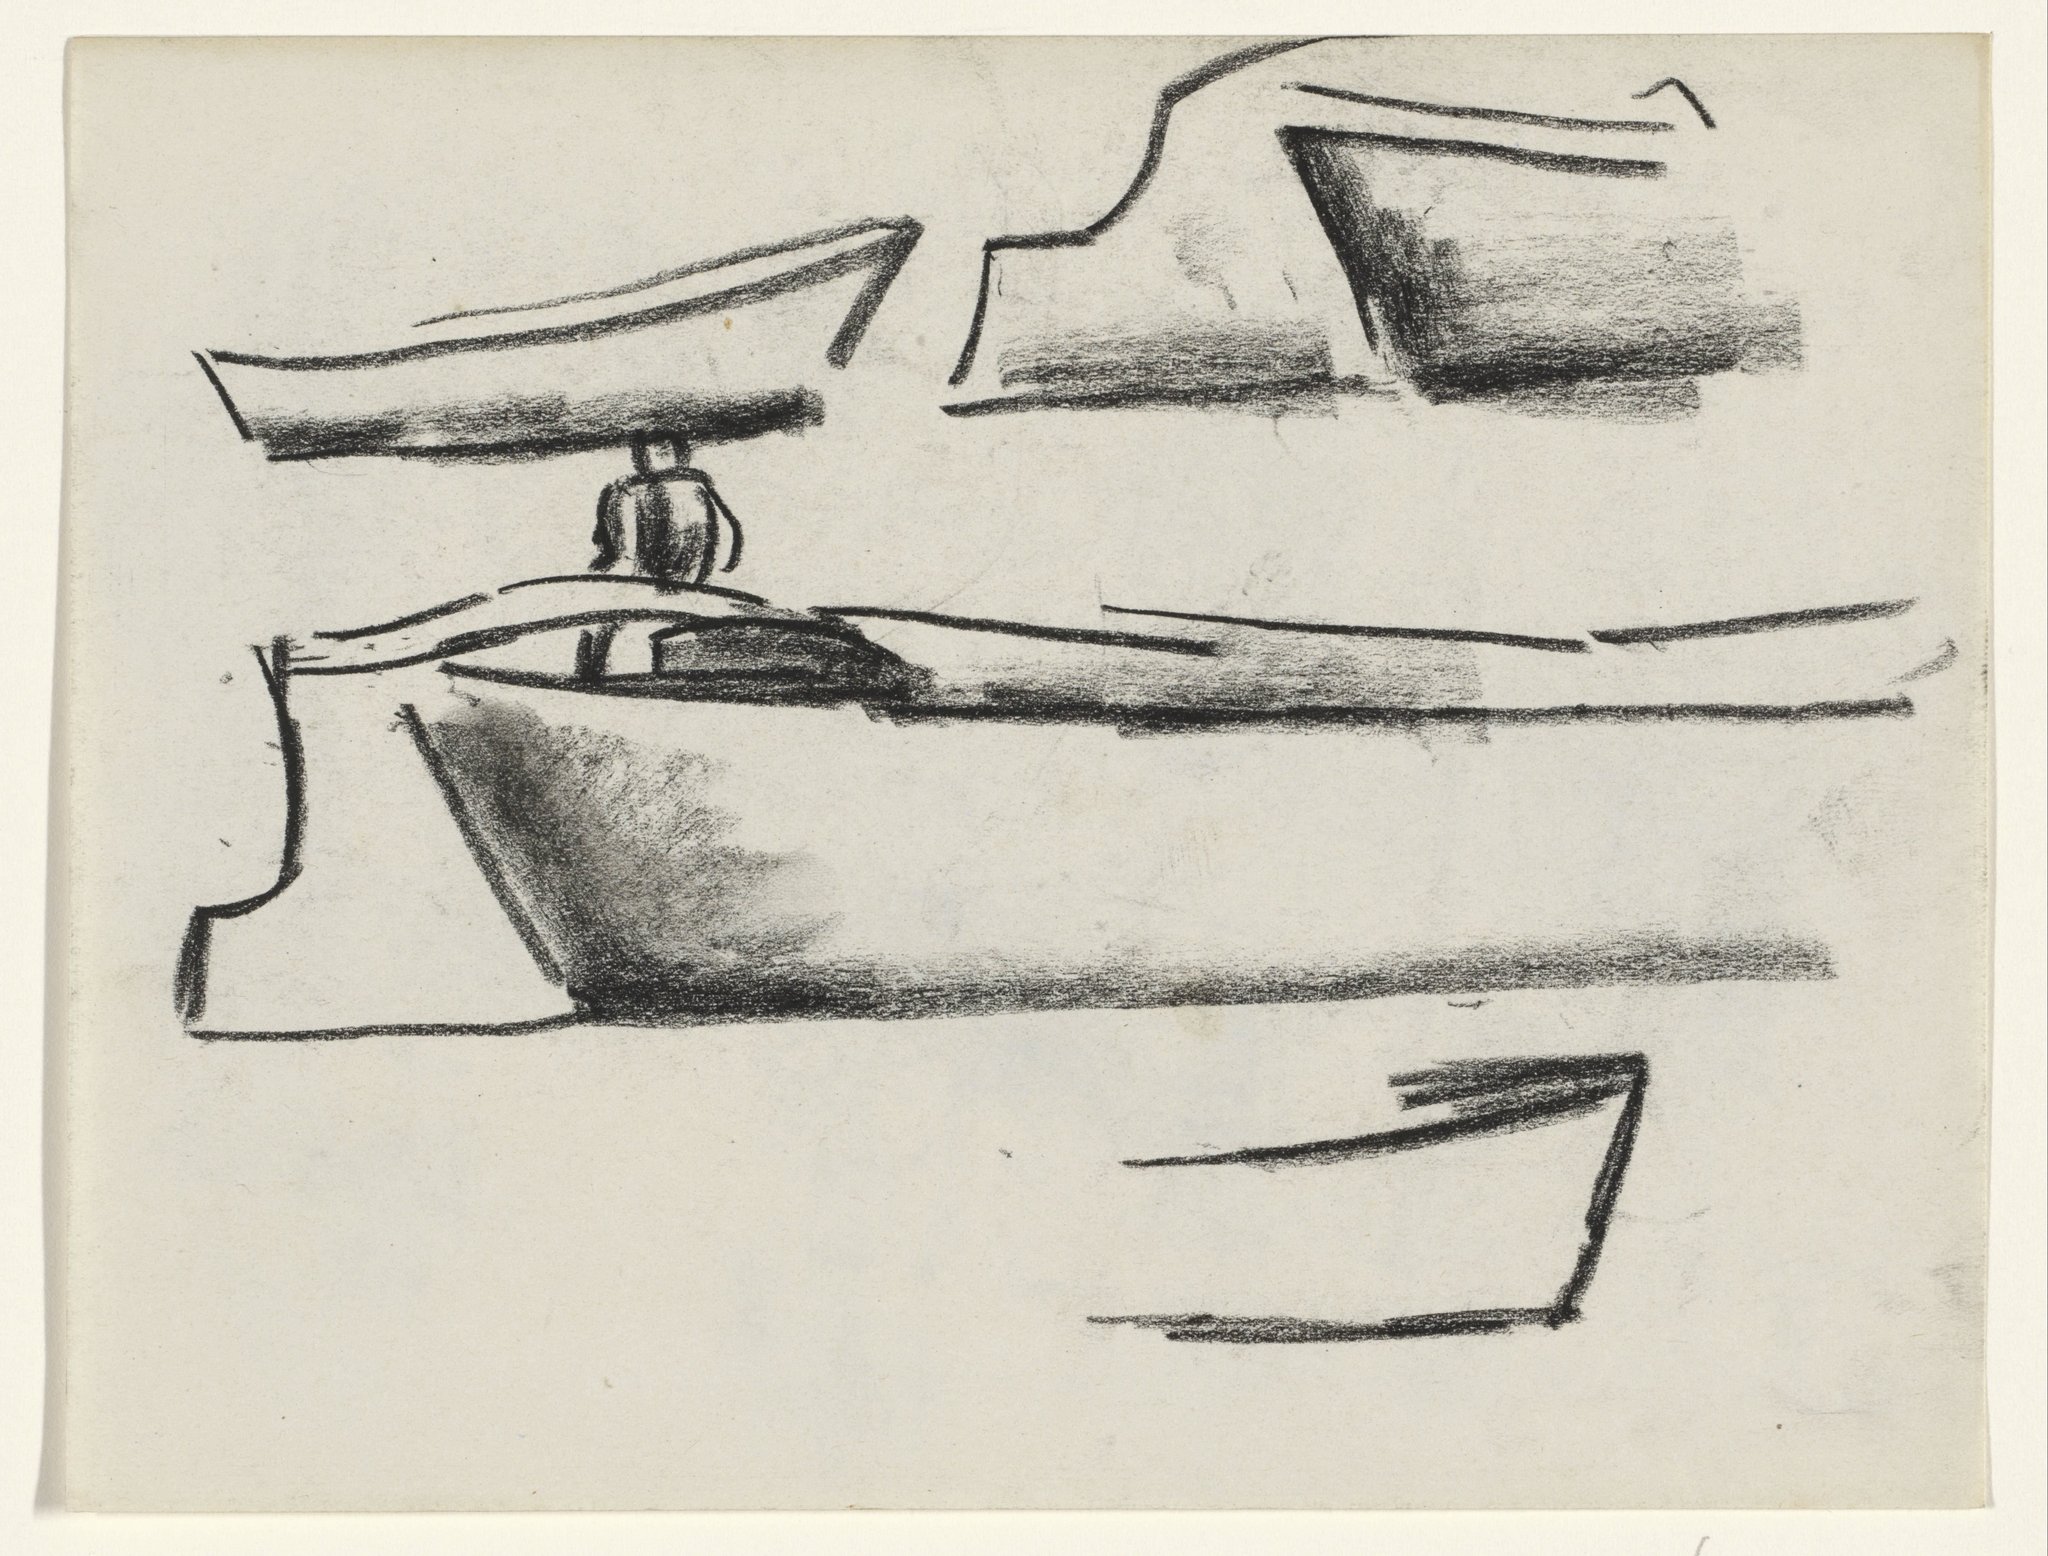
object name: drawing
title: Schip met een man aan het roer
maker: leo gestel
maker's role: draughtsman, print maker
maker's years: 1881-1941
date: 1891-1941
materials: chalk, paper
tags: ships (in general), male sex; man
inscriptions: collector's mark: Lugt 2228